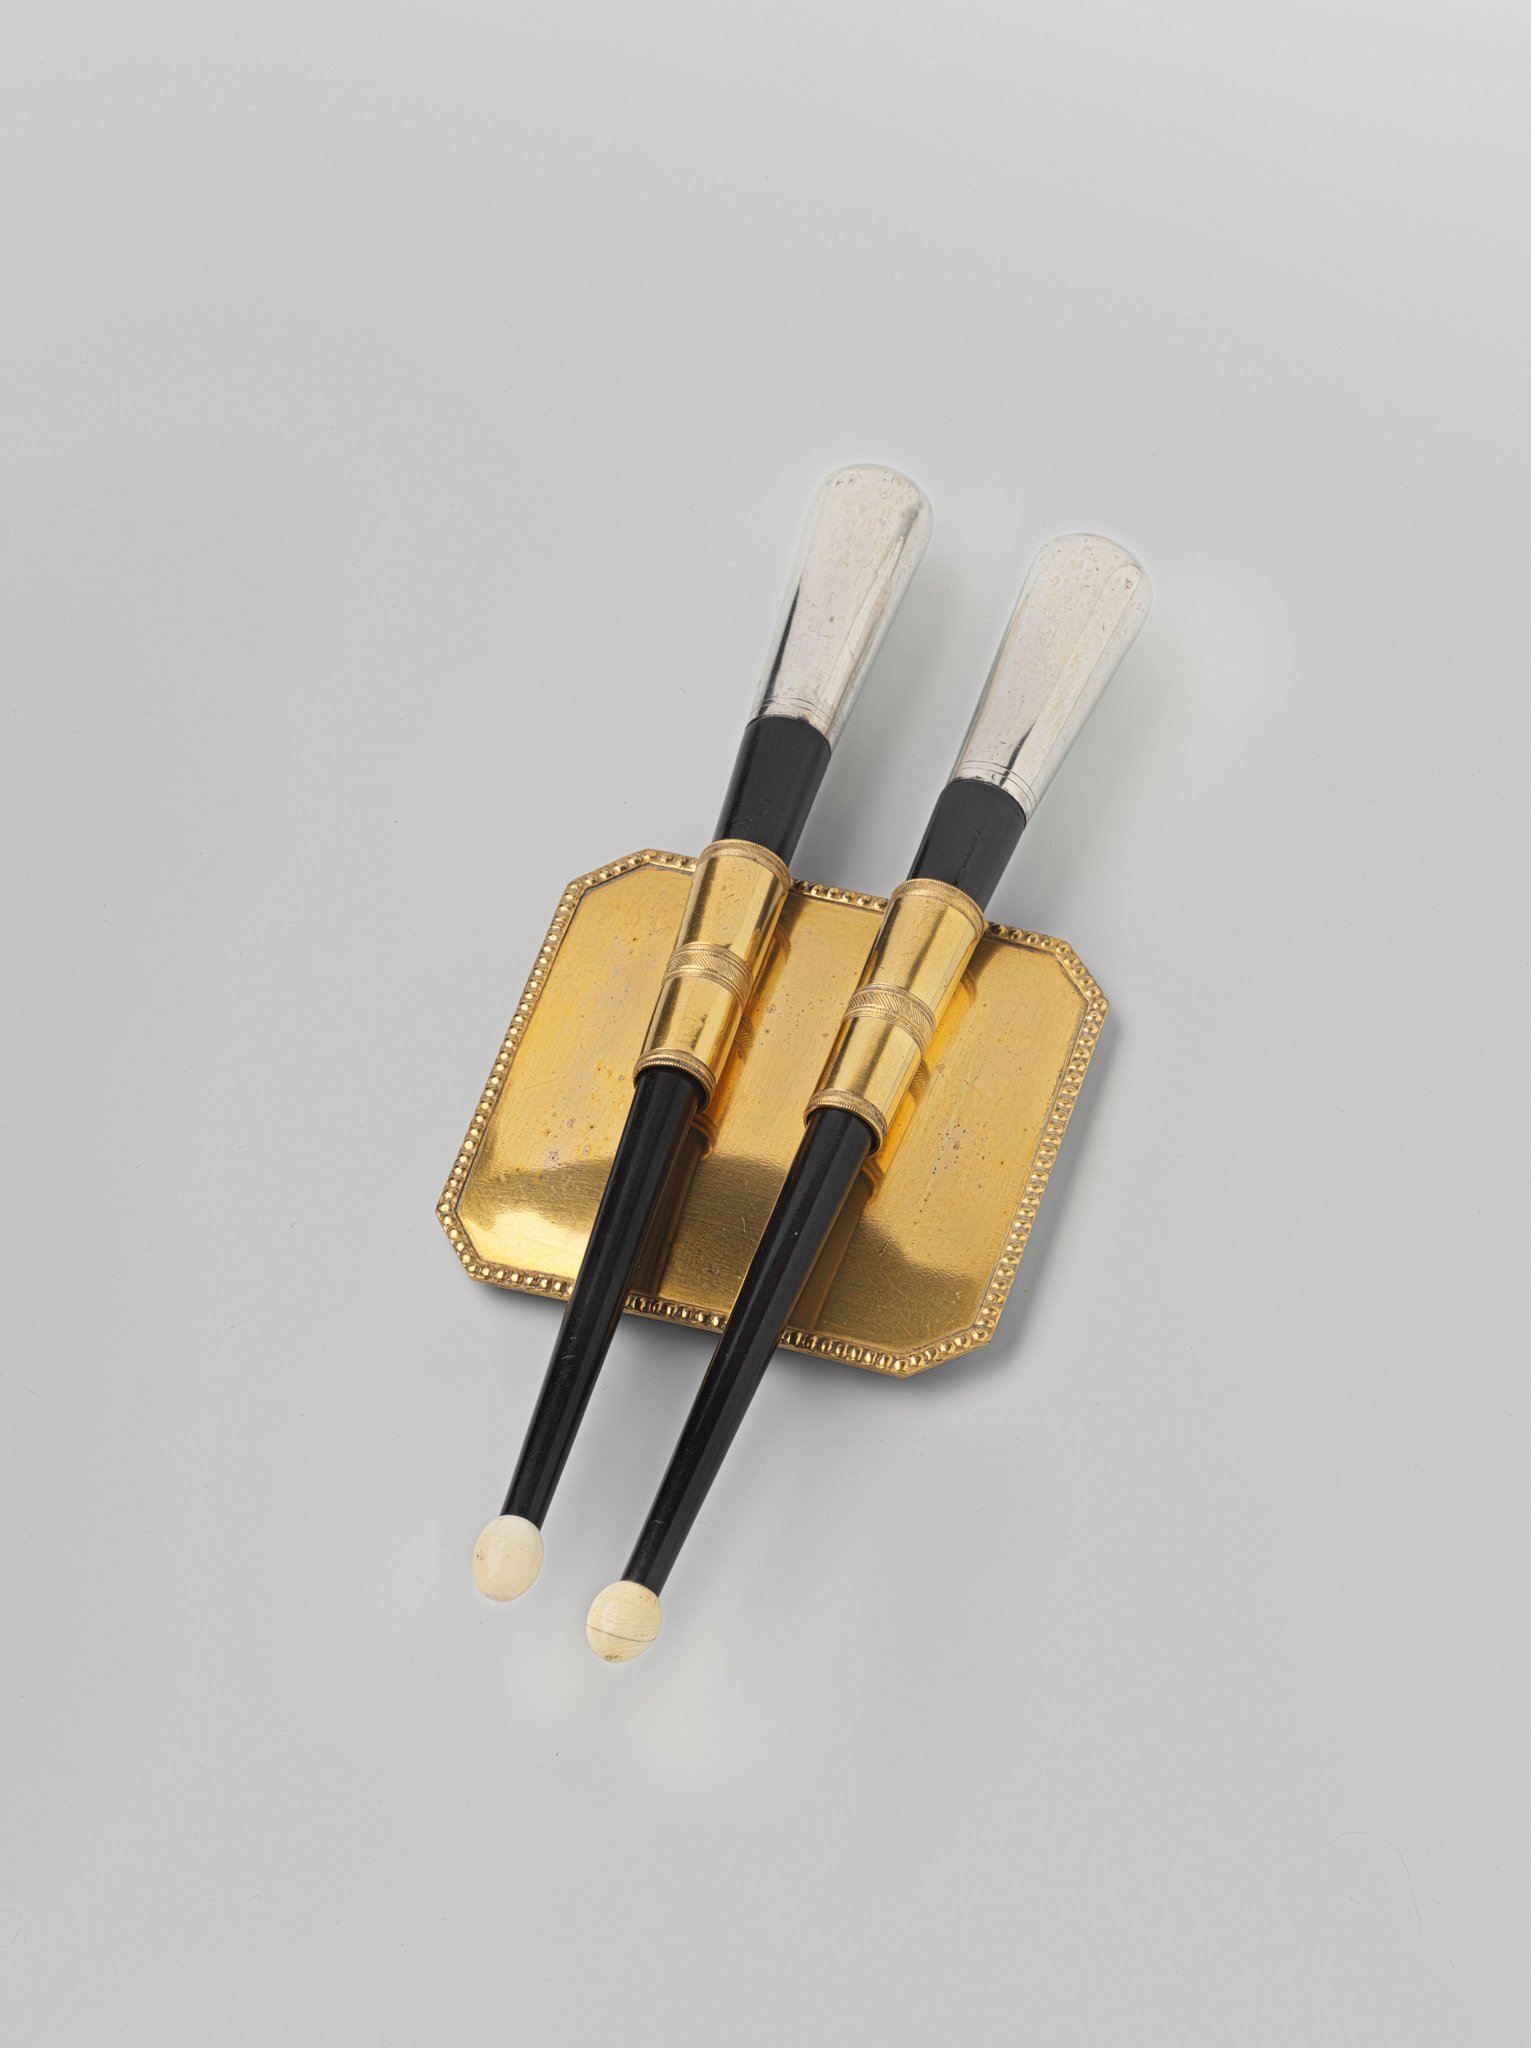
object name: element of musical instrument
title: Drumsticks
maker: Anonymous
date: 1817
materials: wood, ivory, silver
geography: netherlands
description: Een ebbenhouten tromstok met ivoren knop.